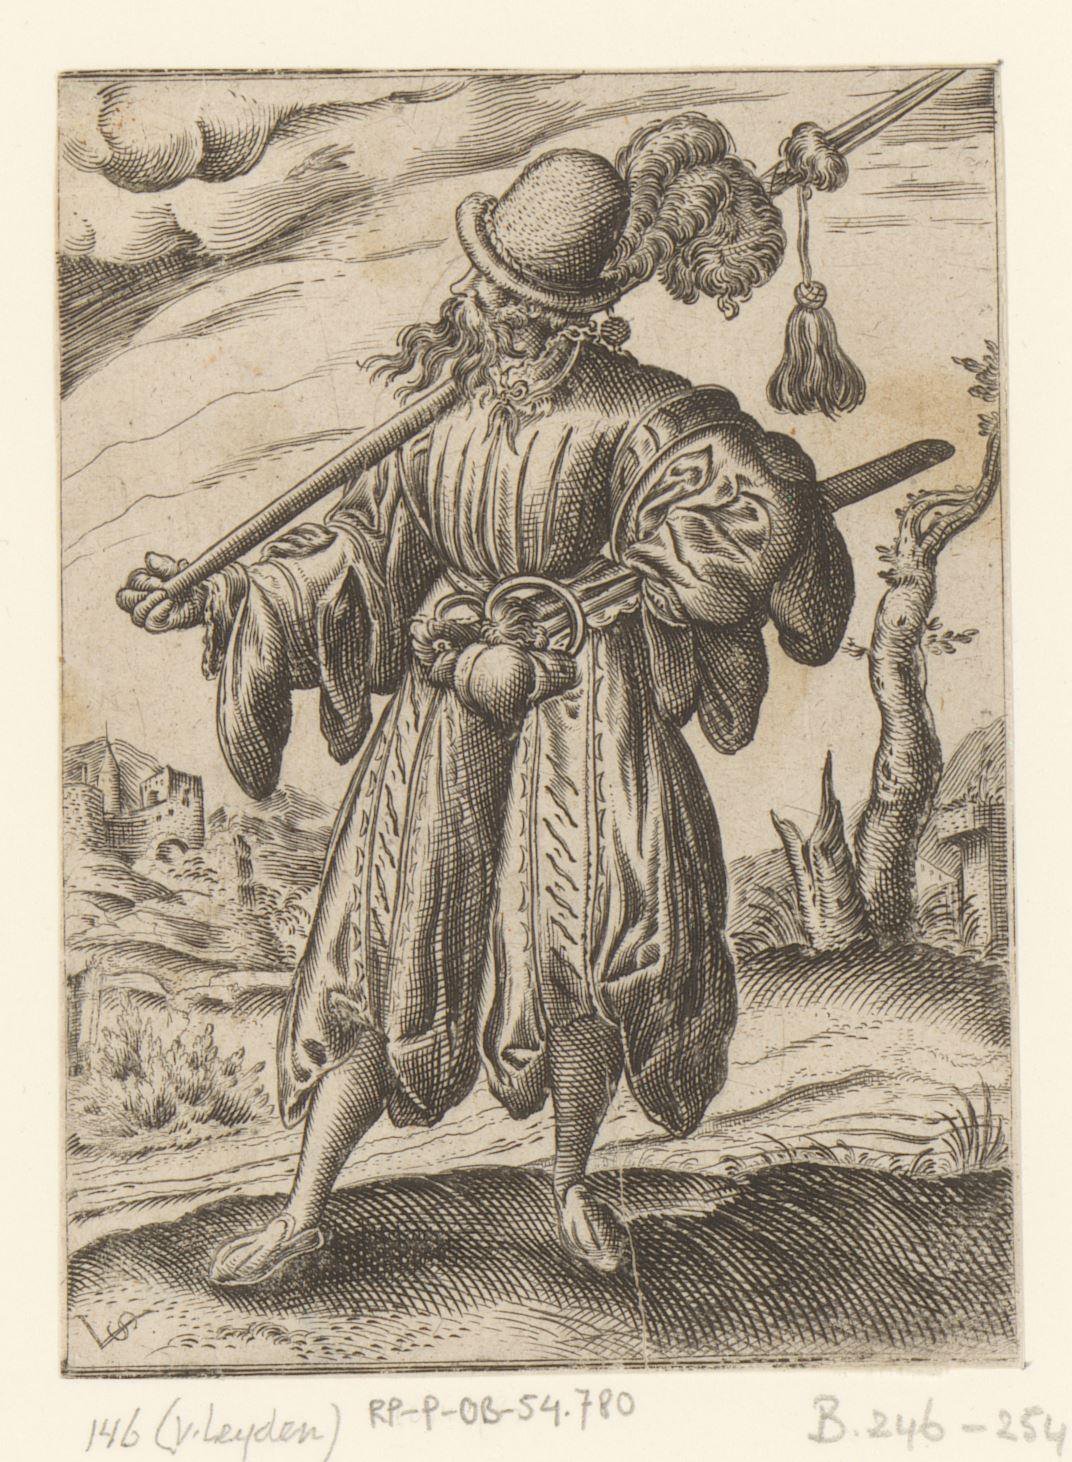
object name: print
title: Militaire figuren staand in landschappen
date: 1524-1612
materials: paper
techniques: engraving, etching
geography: nuremberg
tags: ranks in the army, the soldier; the soldier's life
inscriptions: collector's mark: Lugt 2228, number: ‘146’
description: Maakt deel uit van een serie van elf prenten met voorstellingen van militaire figuren.